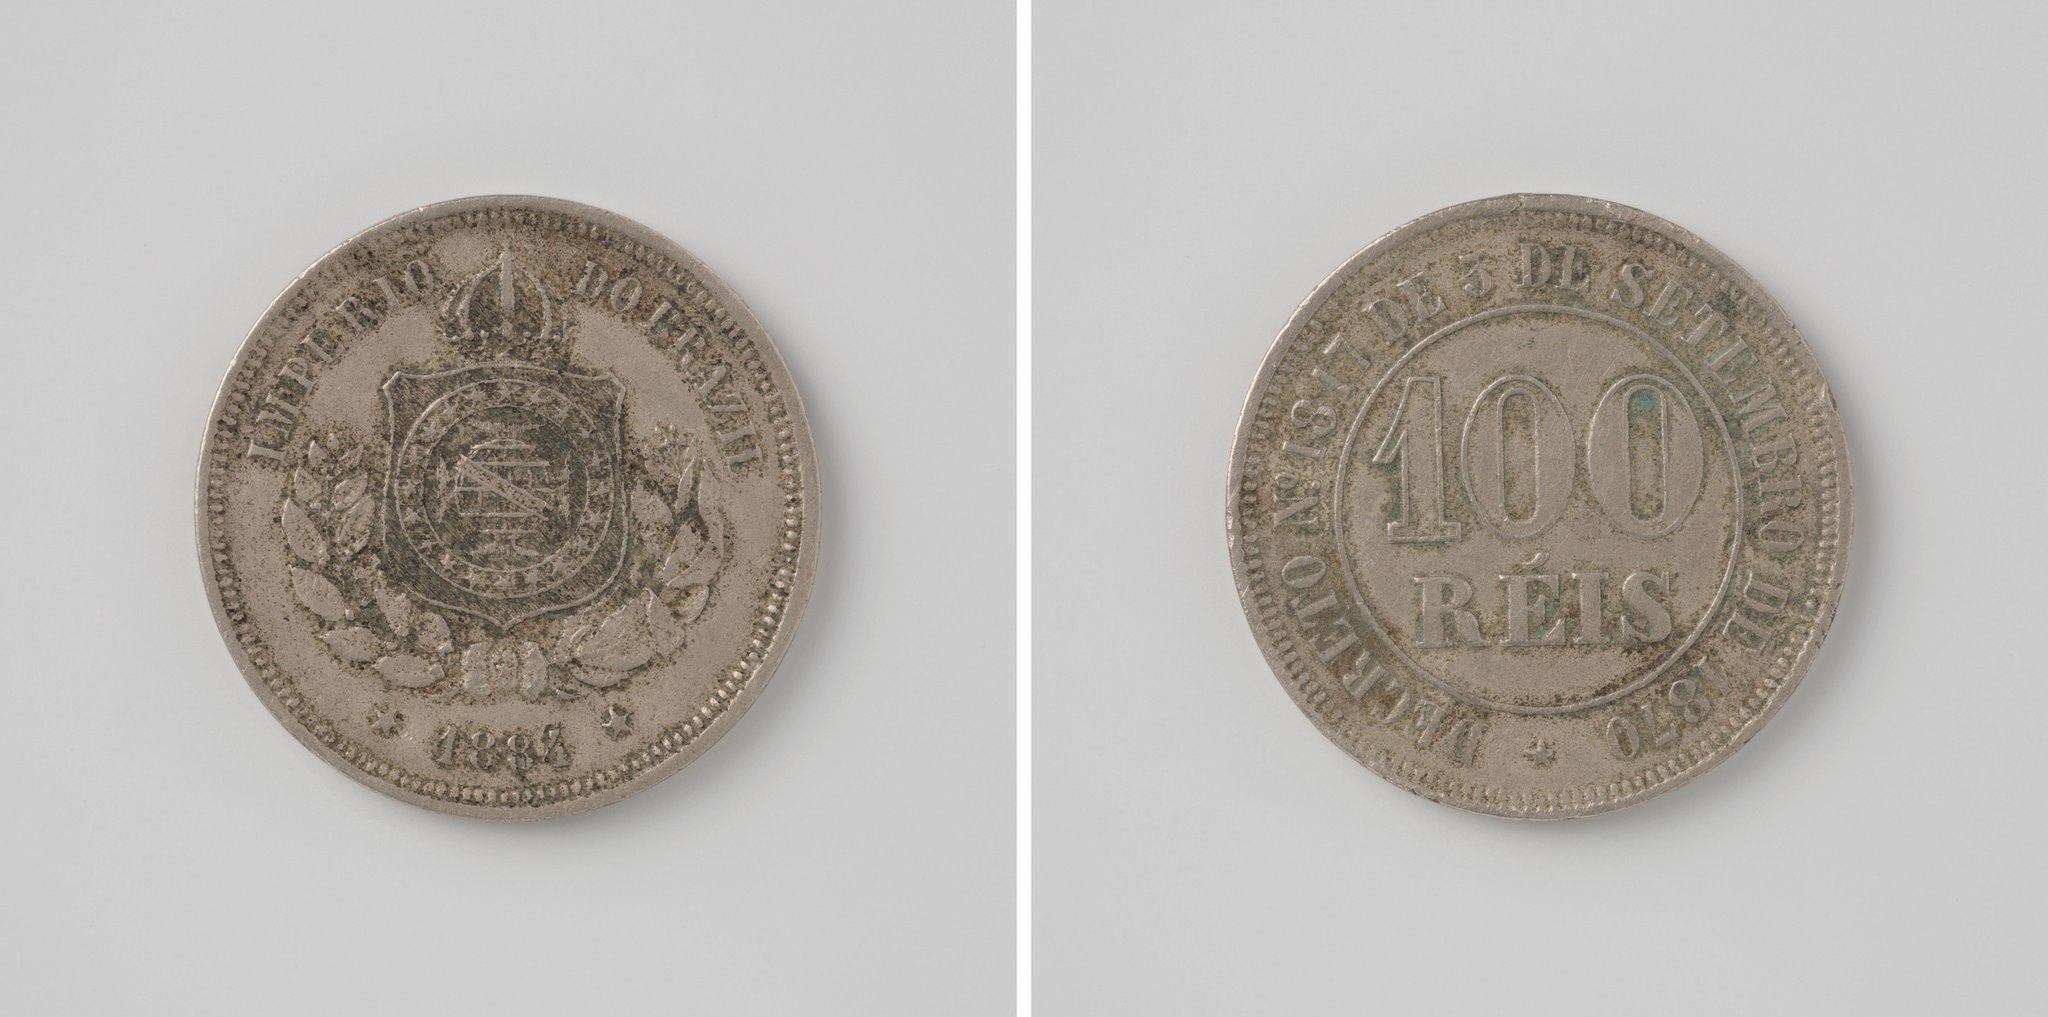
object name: coin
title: 100 reis van het keizerrijk Brazilië van D. Pedro II, 1884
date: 1884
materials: nickel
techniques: striking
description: Nikkelen munt. Voorzijde: tussen twee samengebonden takken gekroond wapenschild van Brazilië. In omschrift onderaan jaartal. Keerzijde: binnen cirkel in twee regels waarde-aanduiding: 100 réis. Gladde rand.